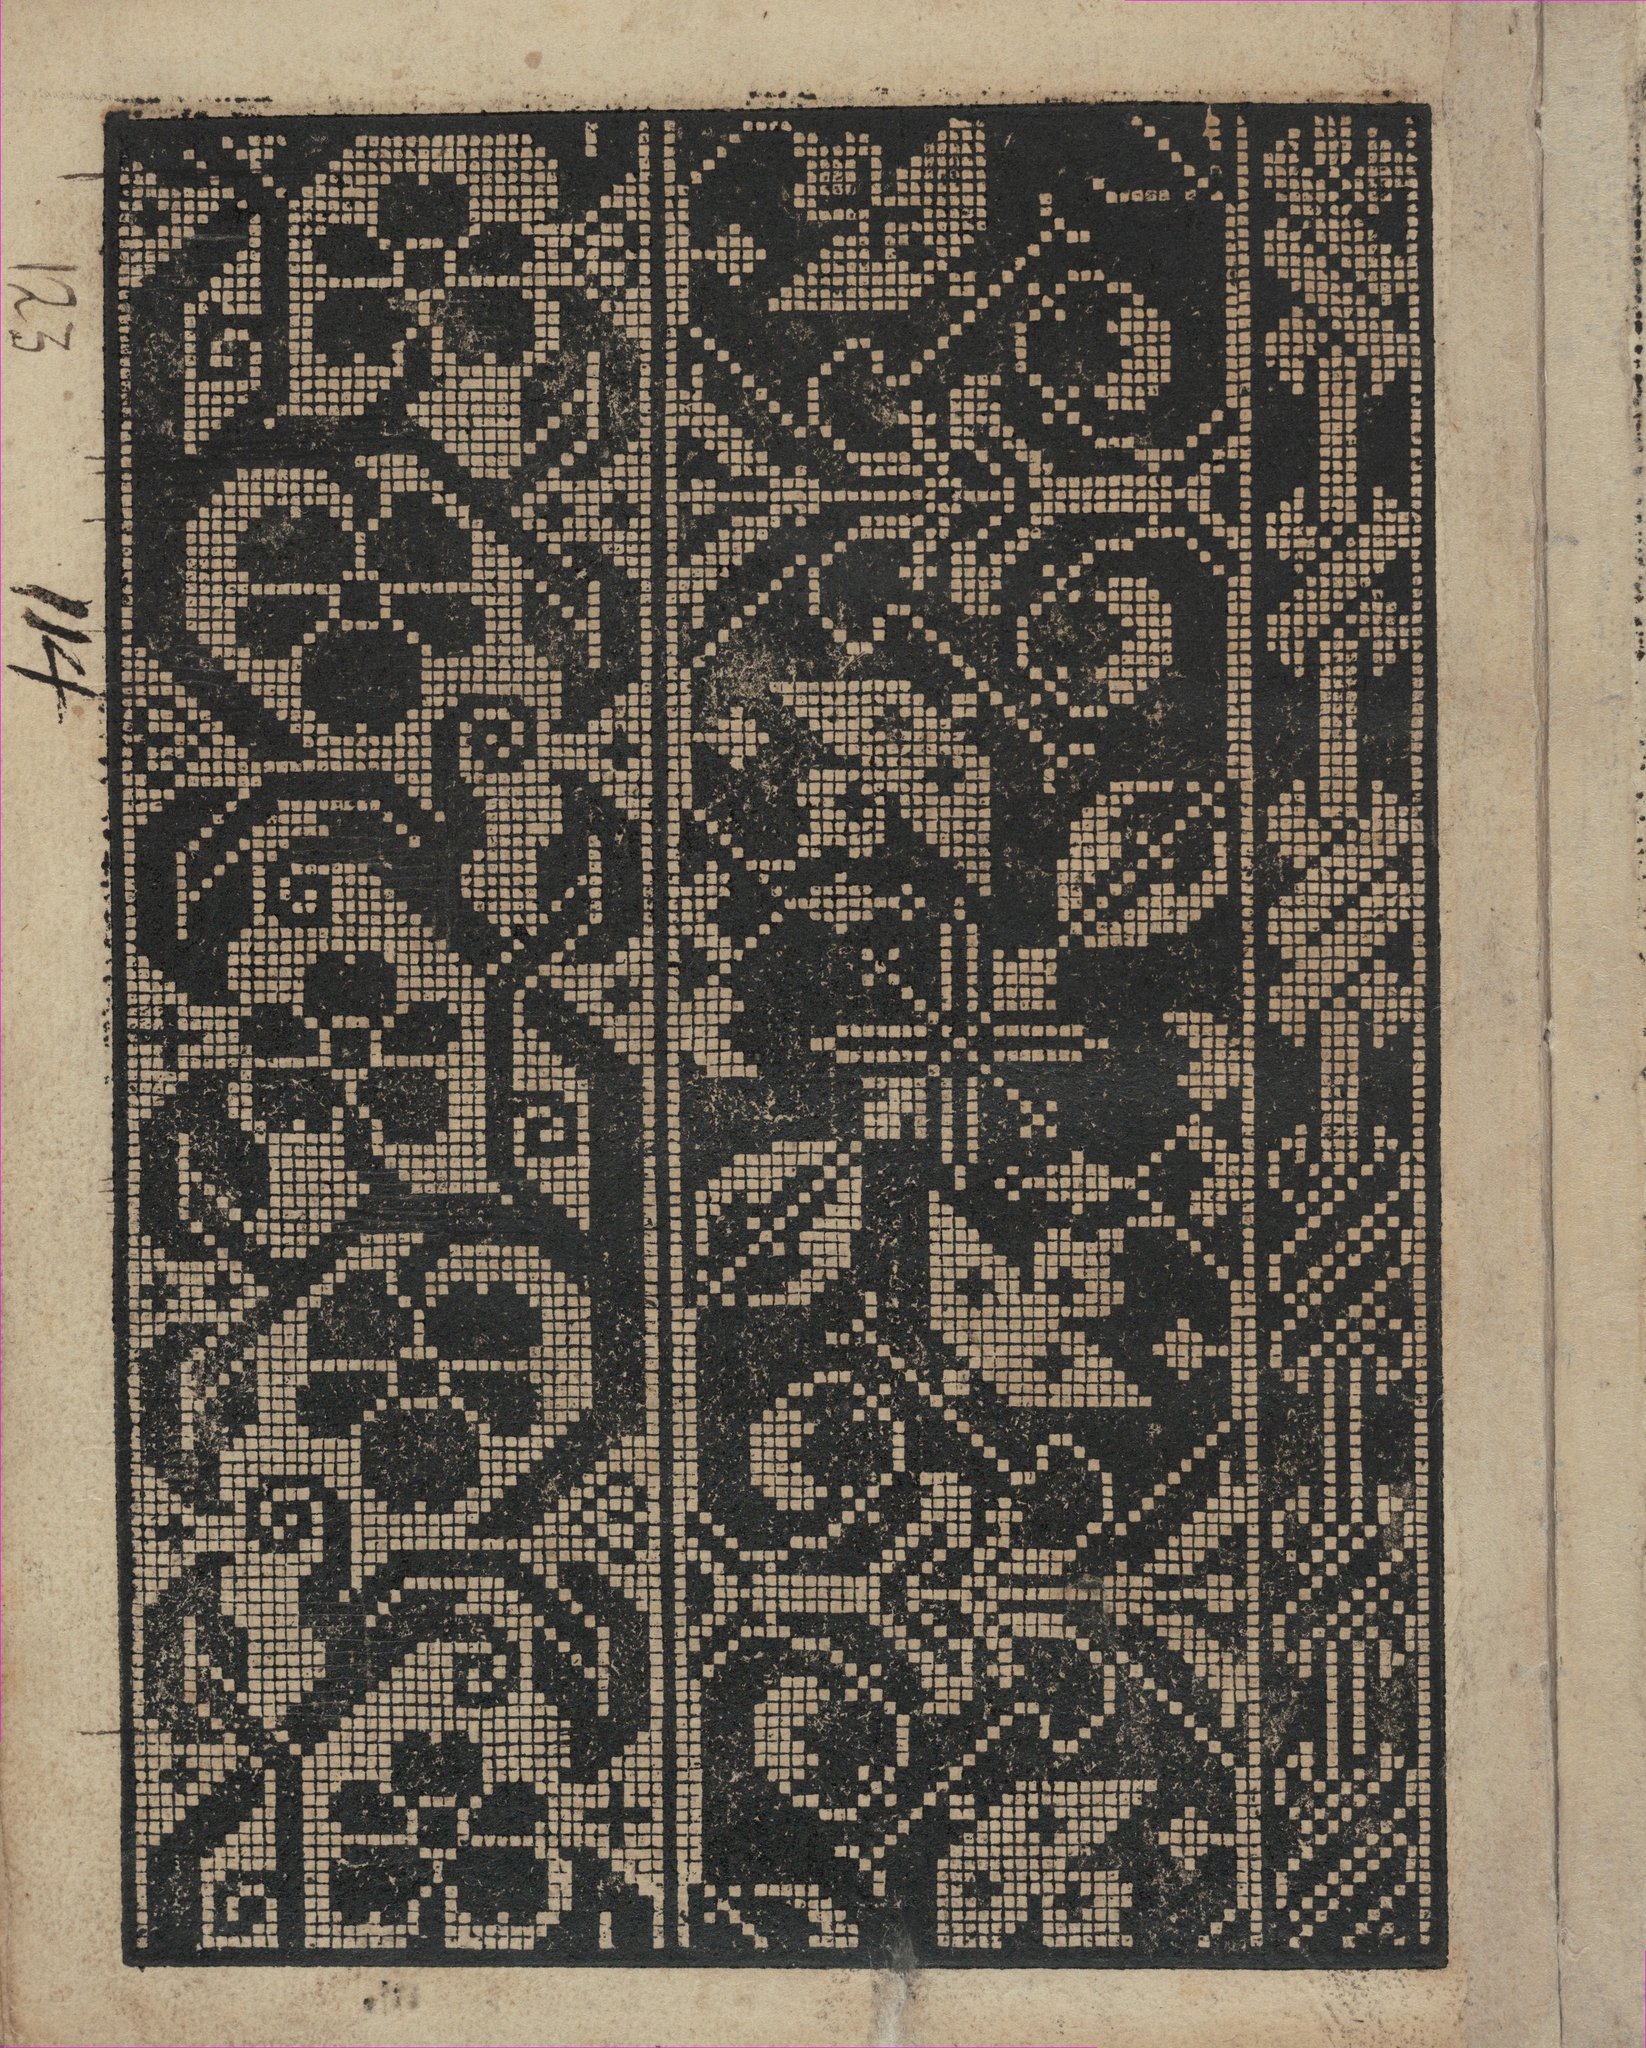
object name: book print ornament architecture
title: Libbretto nouellamete composto per maestro Domenico da Sera...lauorare di ogni sorte di punti, page 3 (verso)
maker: domenico da sera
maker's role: publisher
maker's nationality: french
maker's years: 1500-1599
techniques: woodcut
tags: flowers,vines